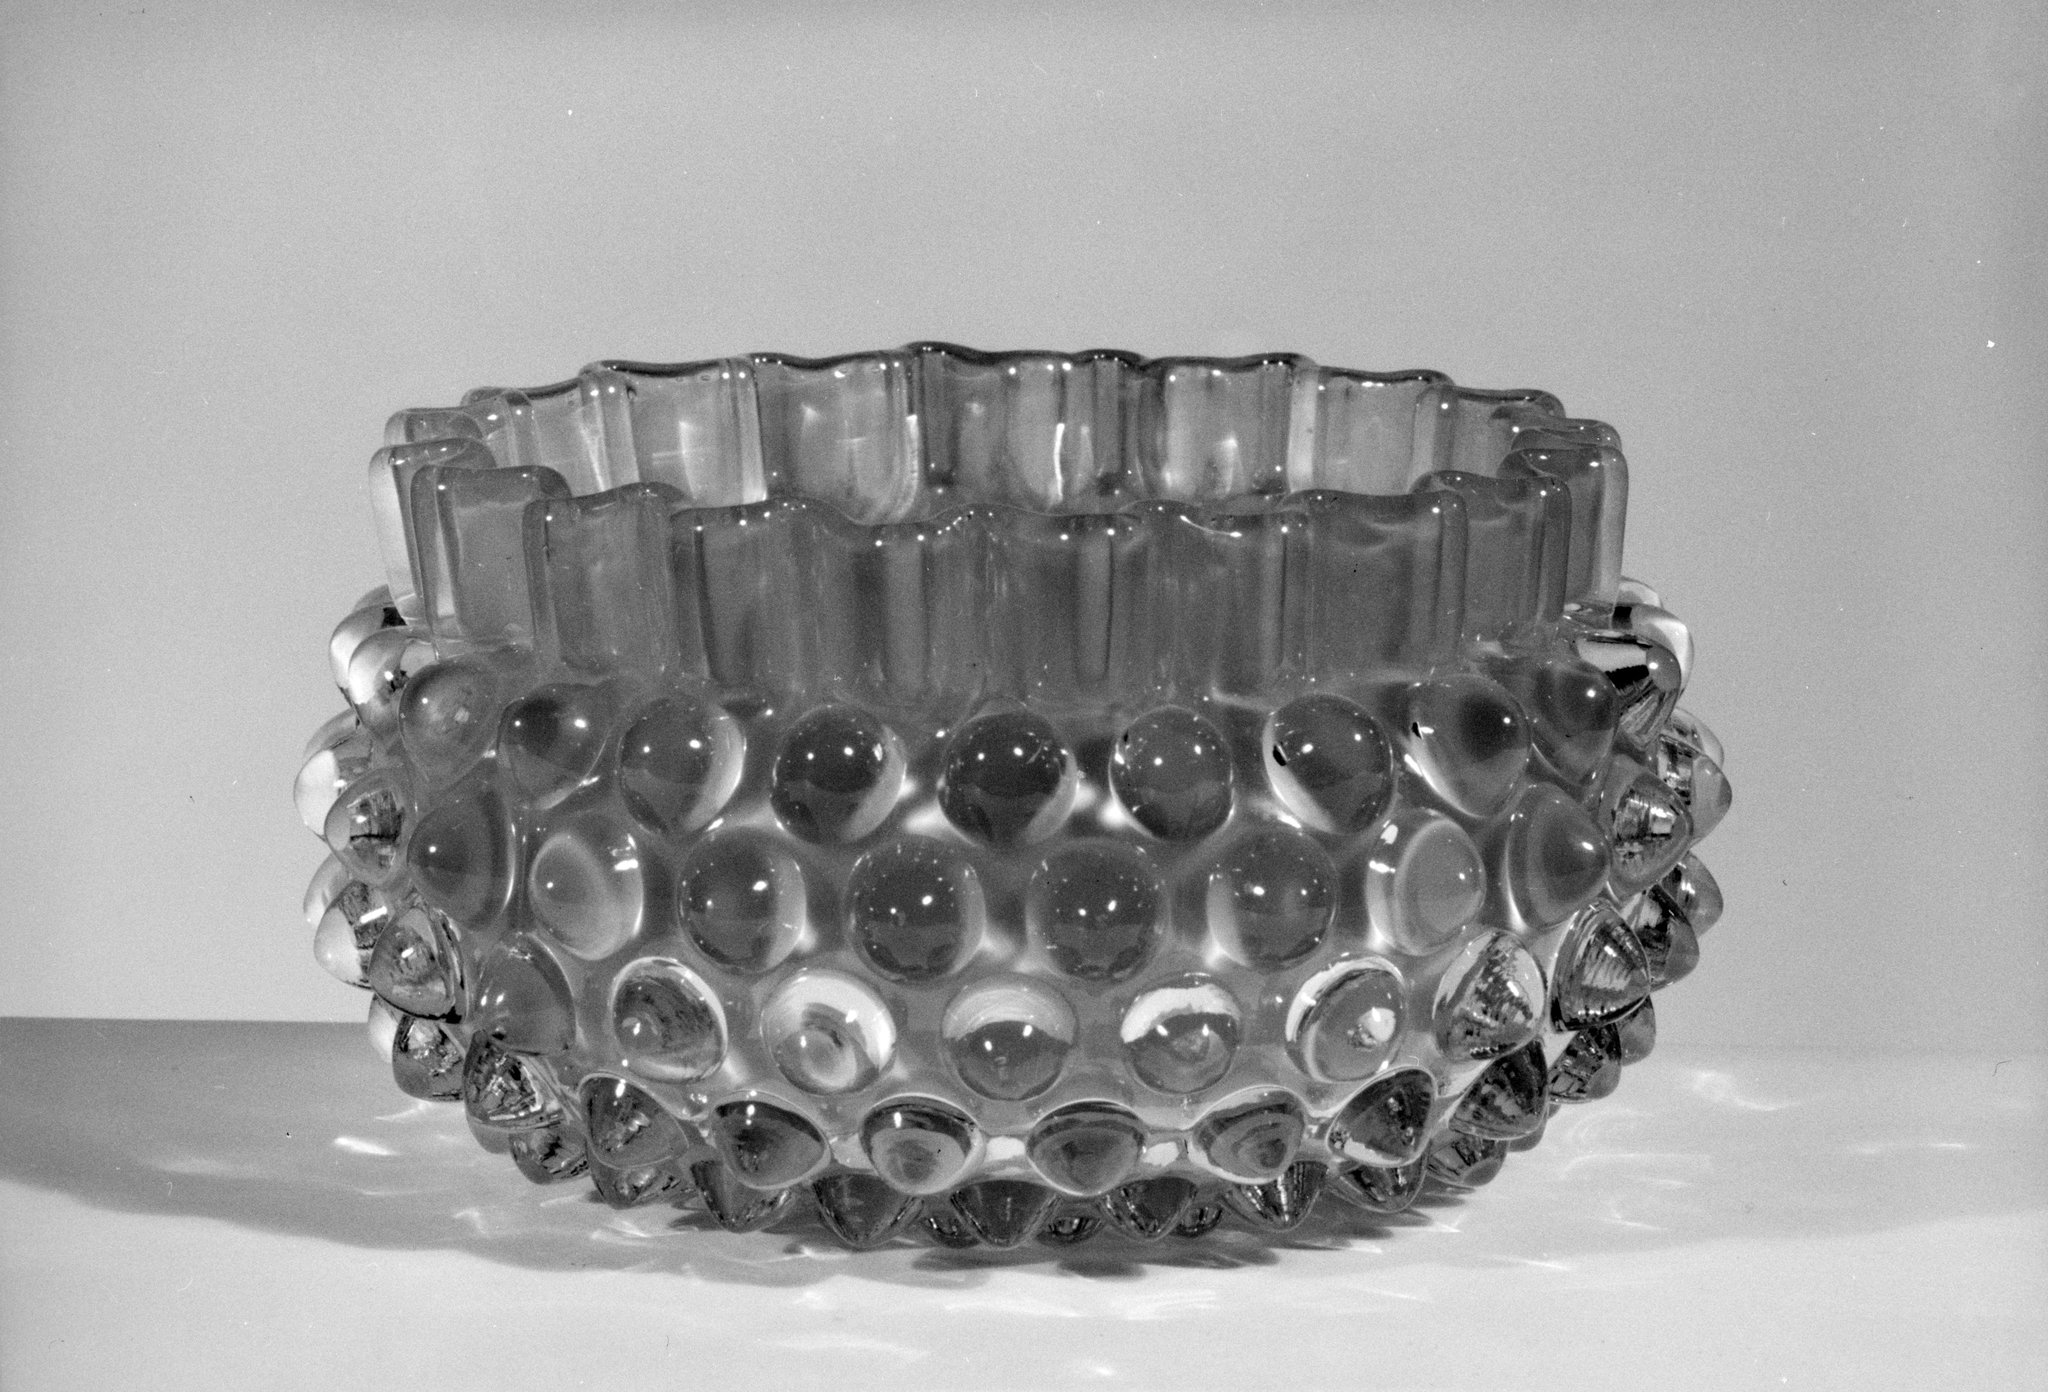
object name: finger bowl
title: Hobnail Finger Bowl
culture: american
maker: hobbs, brockunier and company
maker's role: maker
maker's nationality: american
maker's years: 1863-1891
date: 1886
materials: glass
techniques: pressed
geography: united states